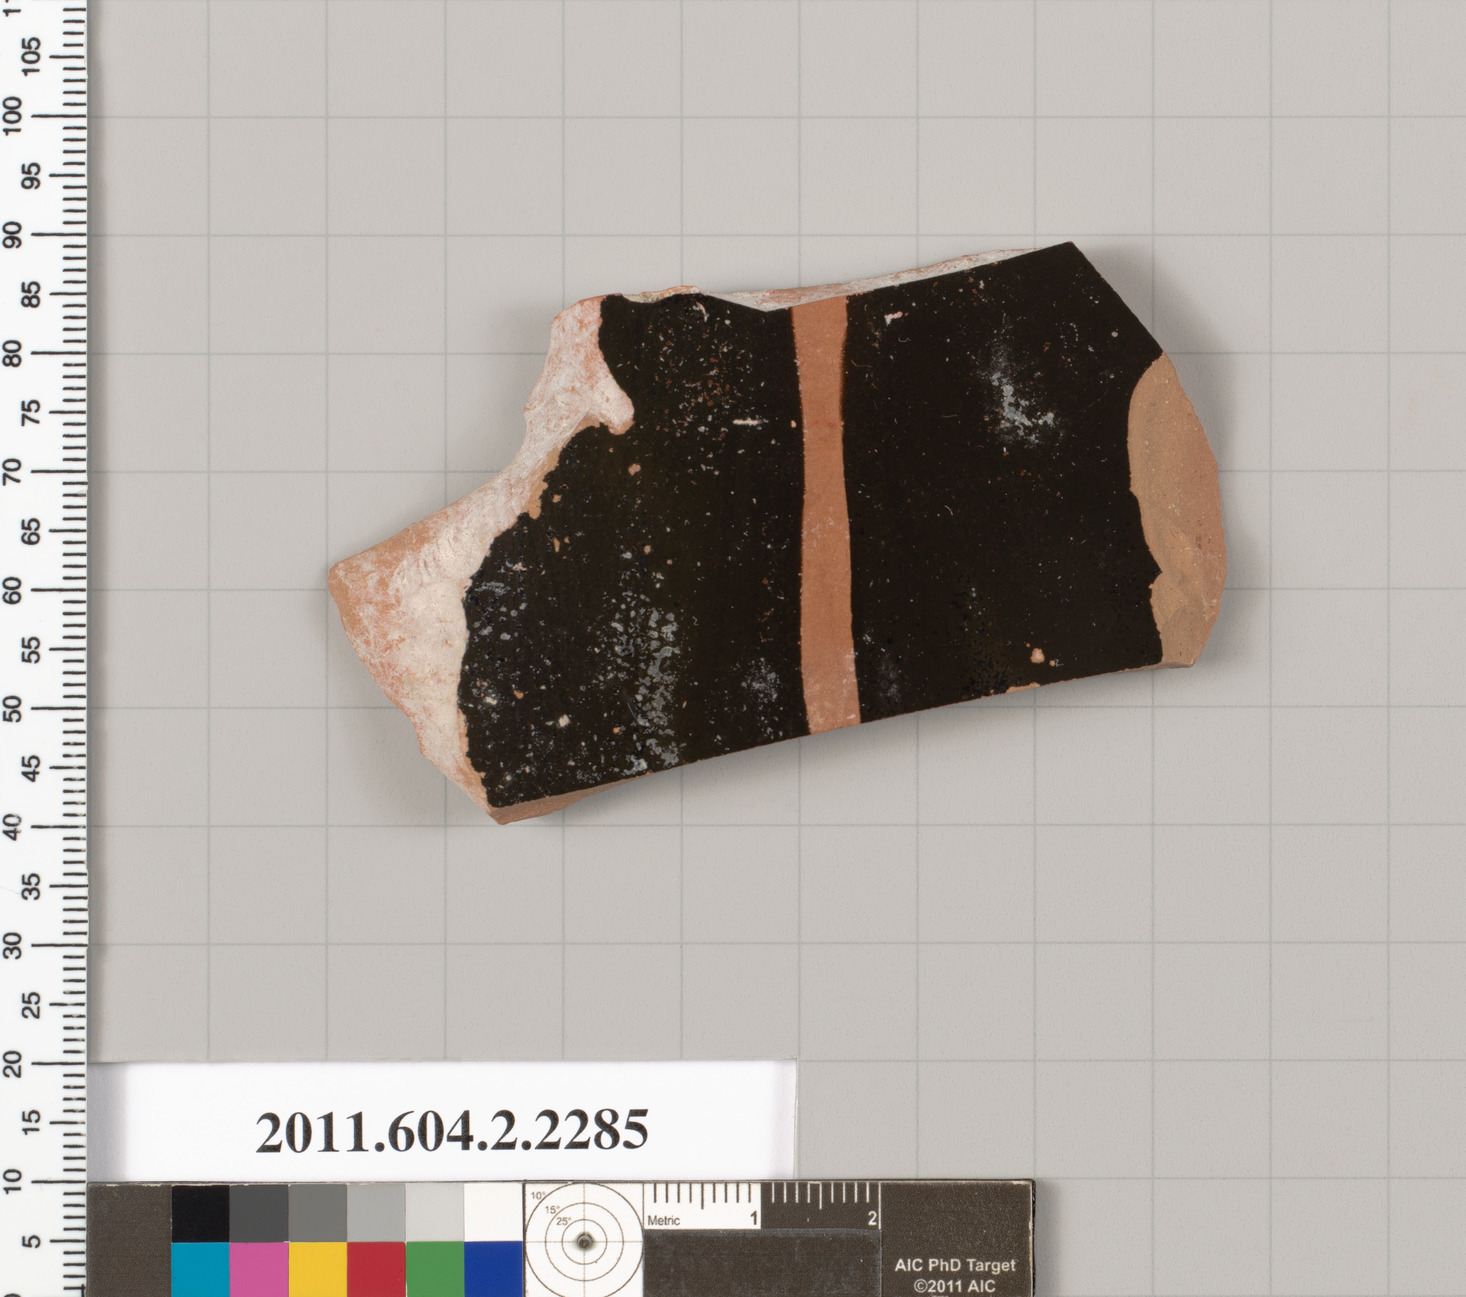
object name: pot fragment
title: Terracotta fragment of a pot; glazed on the inside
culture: greek, attic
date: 460-440 BCE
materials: terracotta